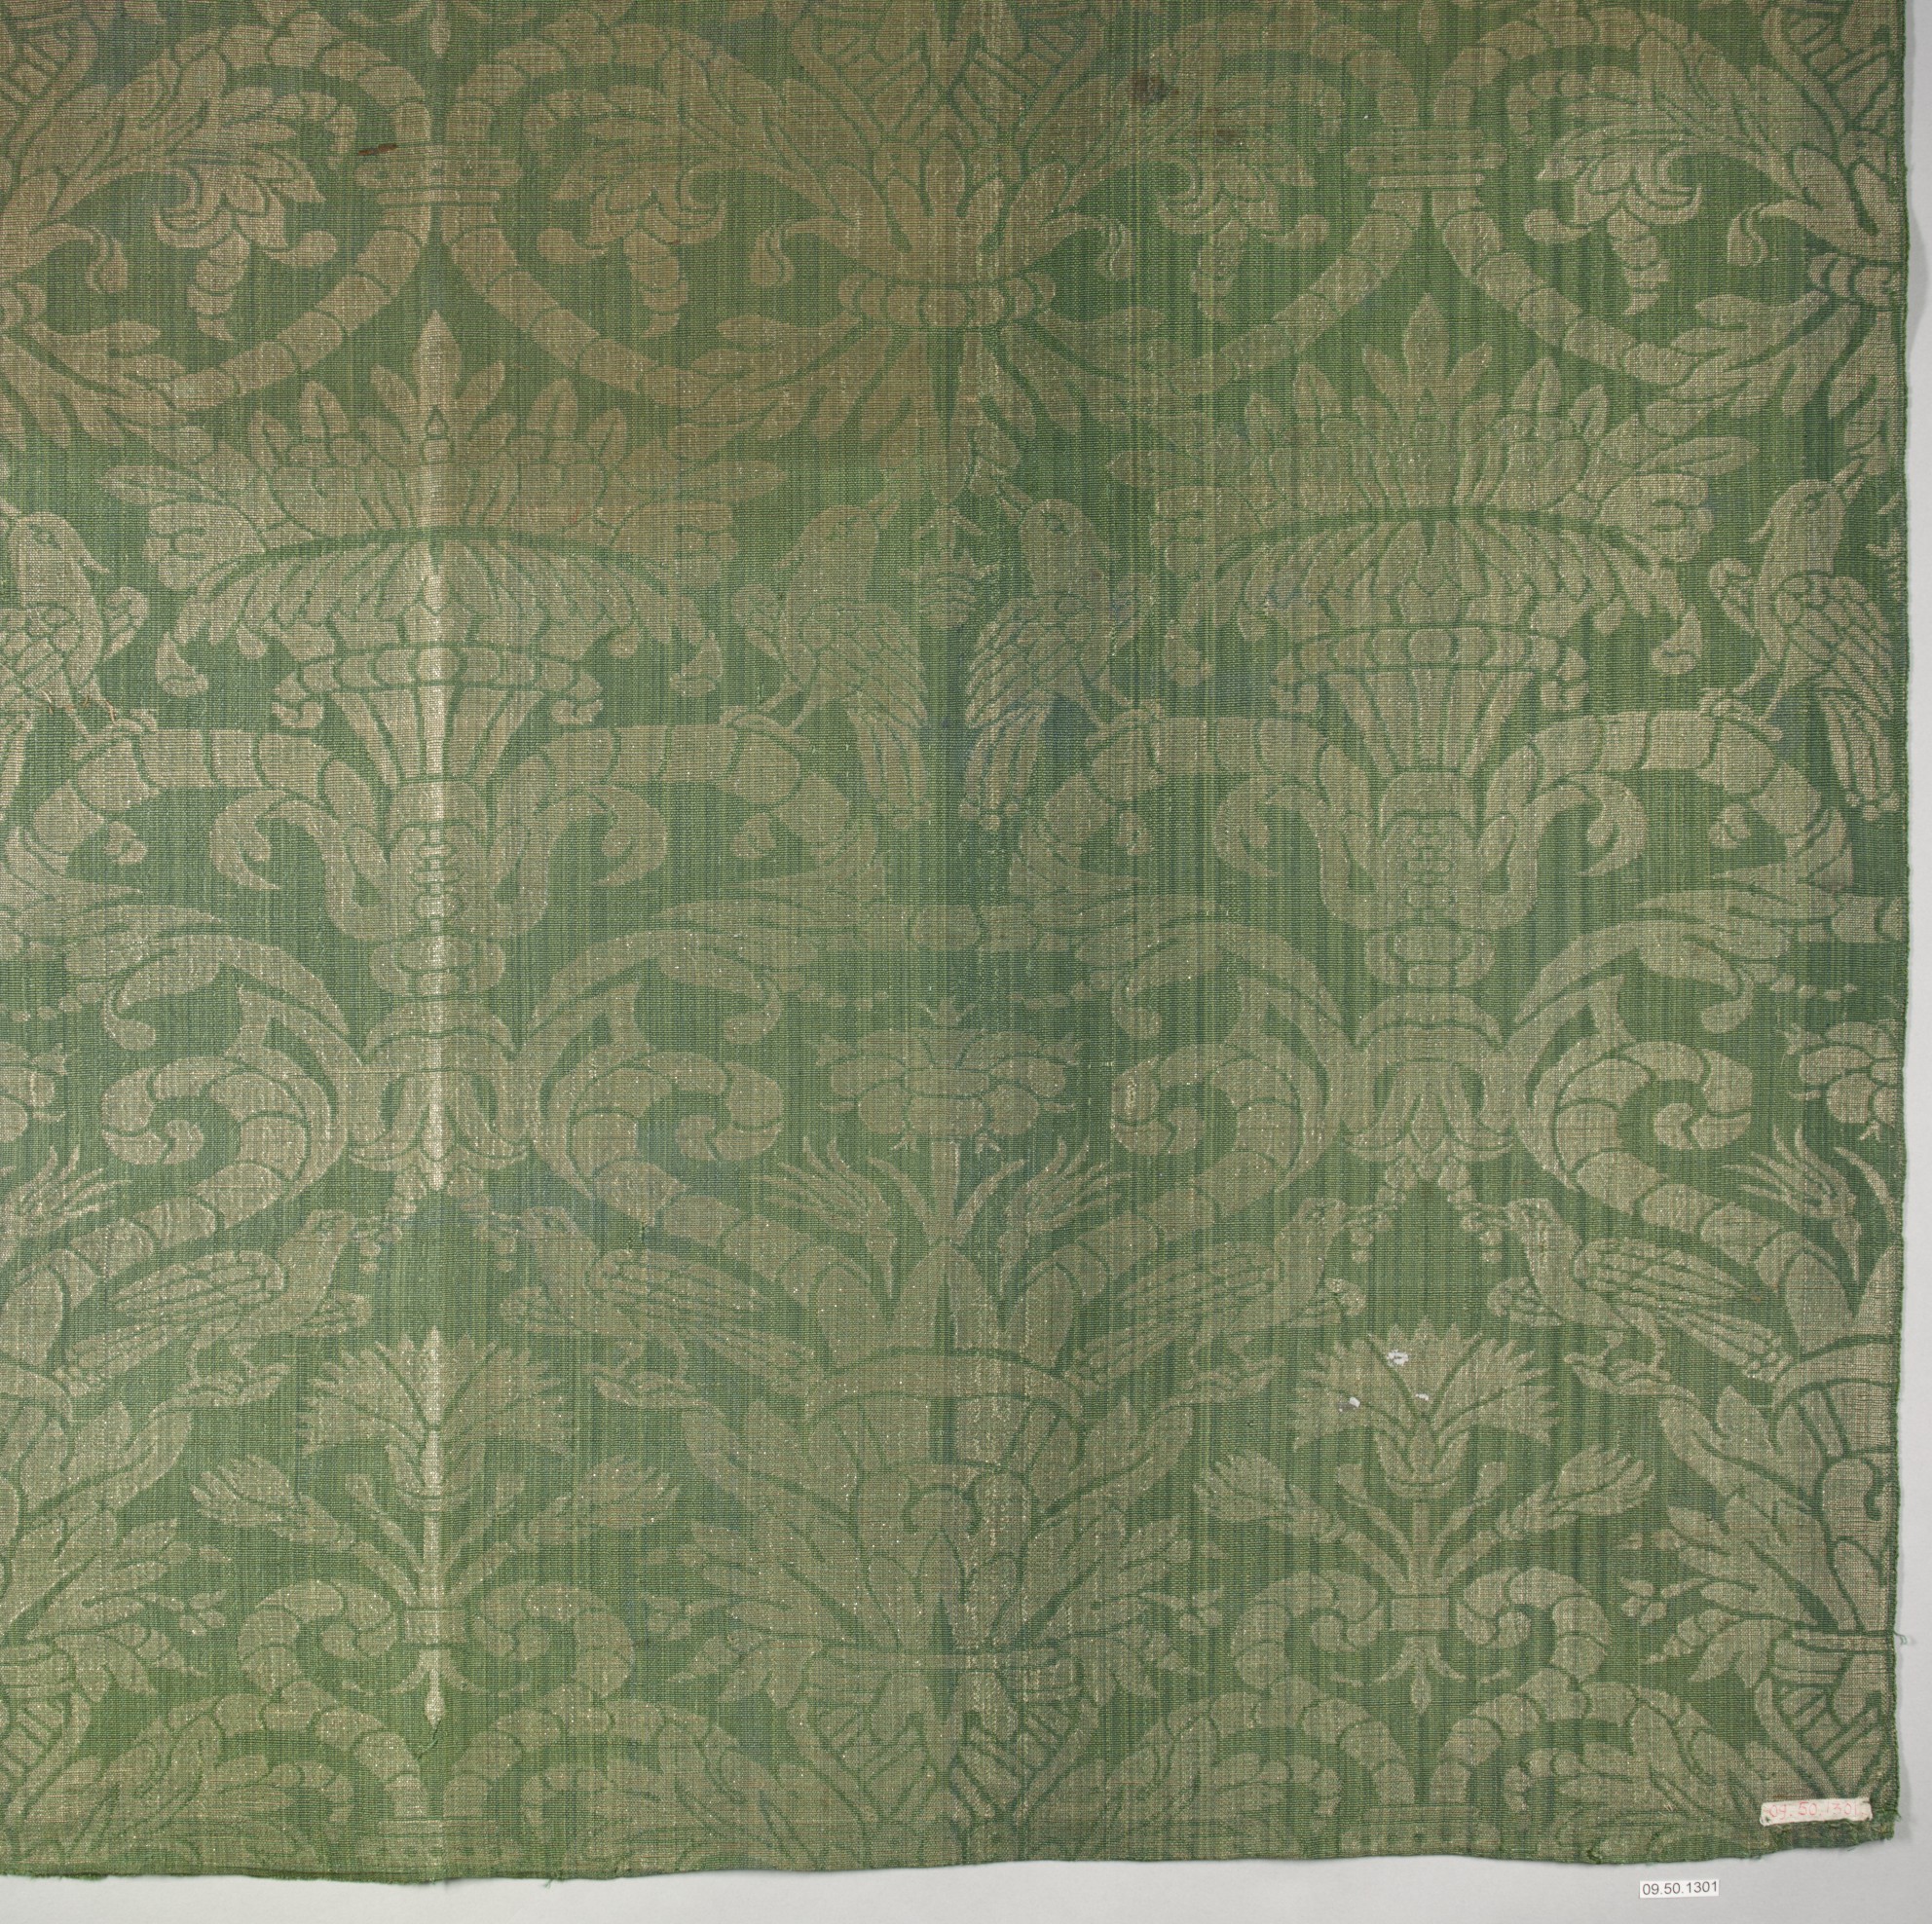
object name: fragment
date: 1701-1800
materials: metal thread, silk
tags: birds